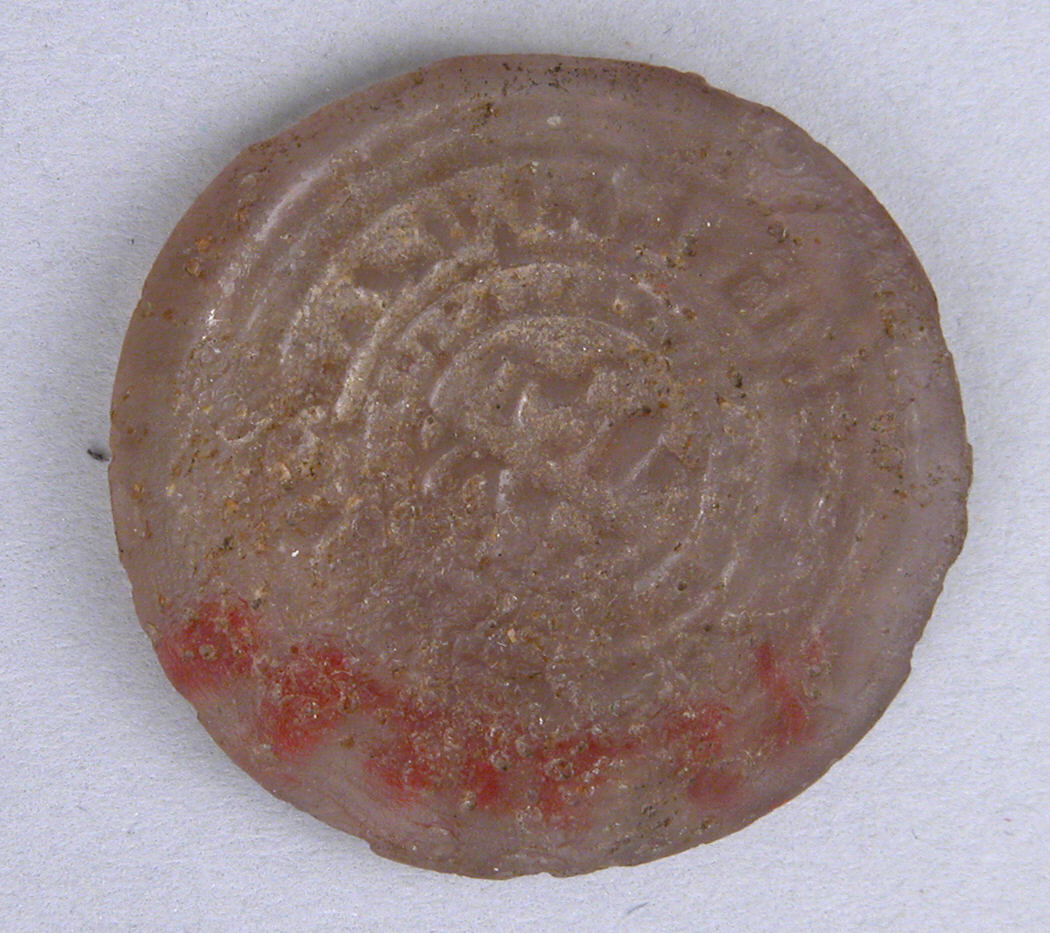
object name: coin weight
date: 901-1100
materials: glass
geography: egypt